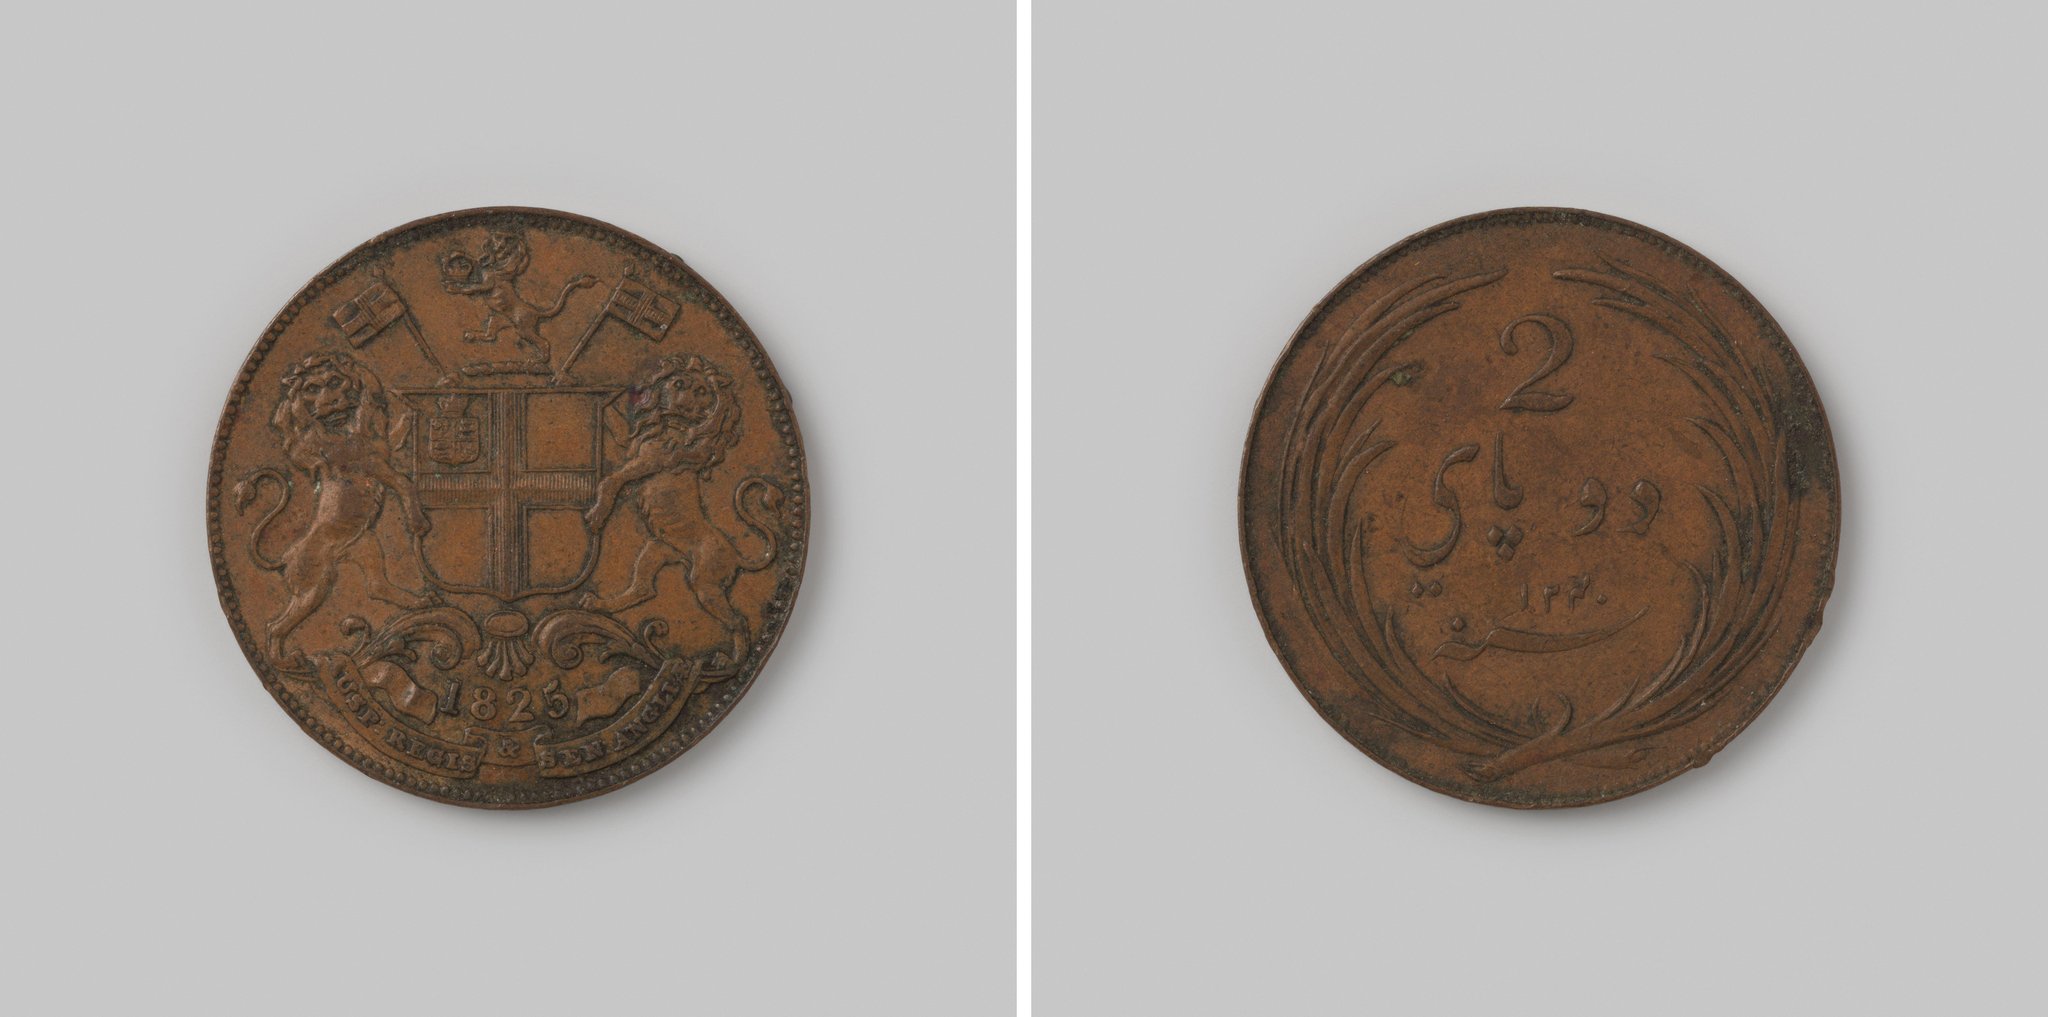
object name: coin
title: Engelse Oostindische Compagnie (EIC), Madras, India, 2 pice, 1825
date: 1825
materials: copper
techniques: striking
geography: london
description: Koperen munt. Voorzijde: door twee op banderol, waarin opschrift, staande leeuwen met pijl, waaraan vlag, in de klauw, gehouden wapenschild van de EIC, waarboven helmteken. Tussen wapenschild en banderol jaartal. Keerzijde: tussen twee samengebonden takken in twee regels waarde-aanduiding: 2 pice, waaronder jaartal: 1240. Gladde rand.